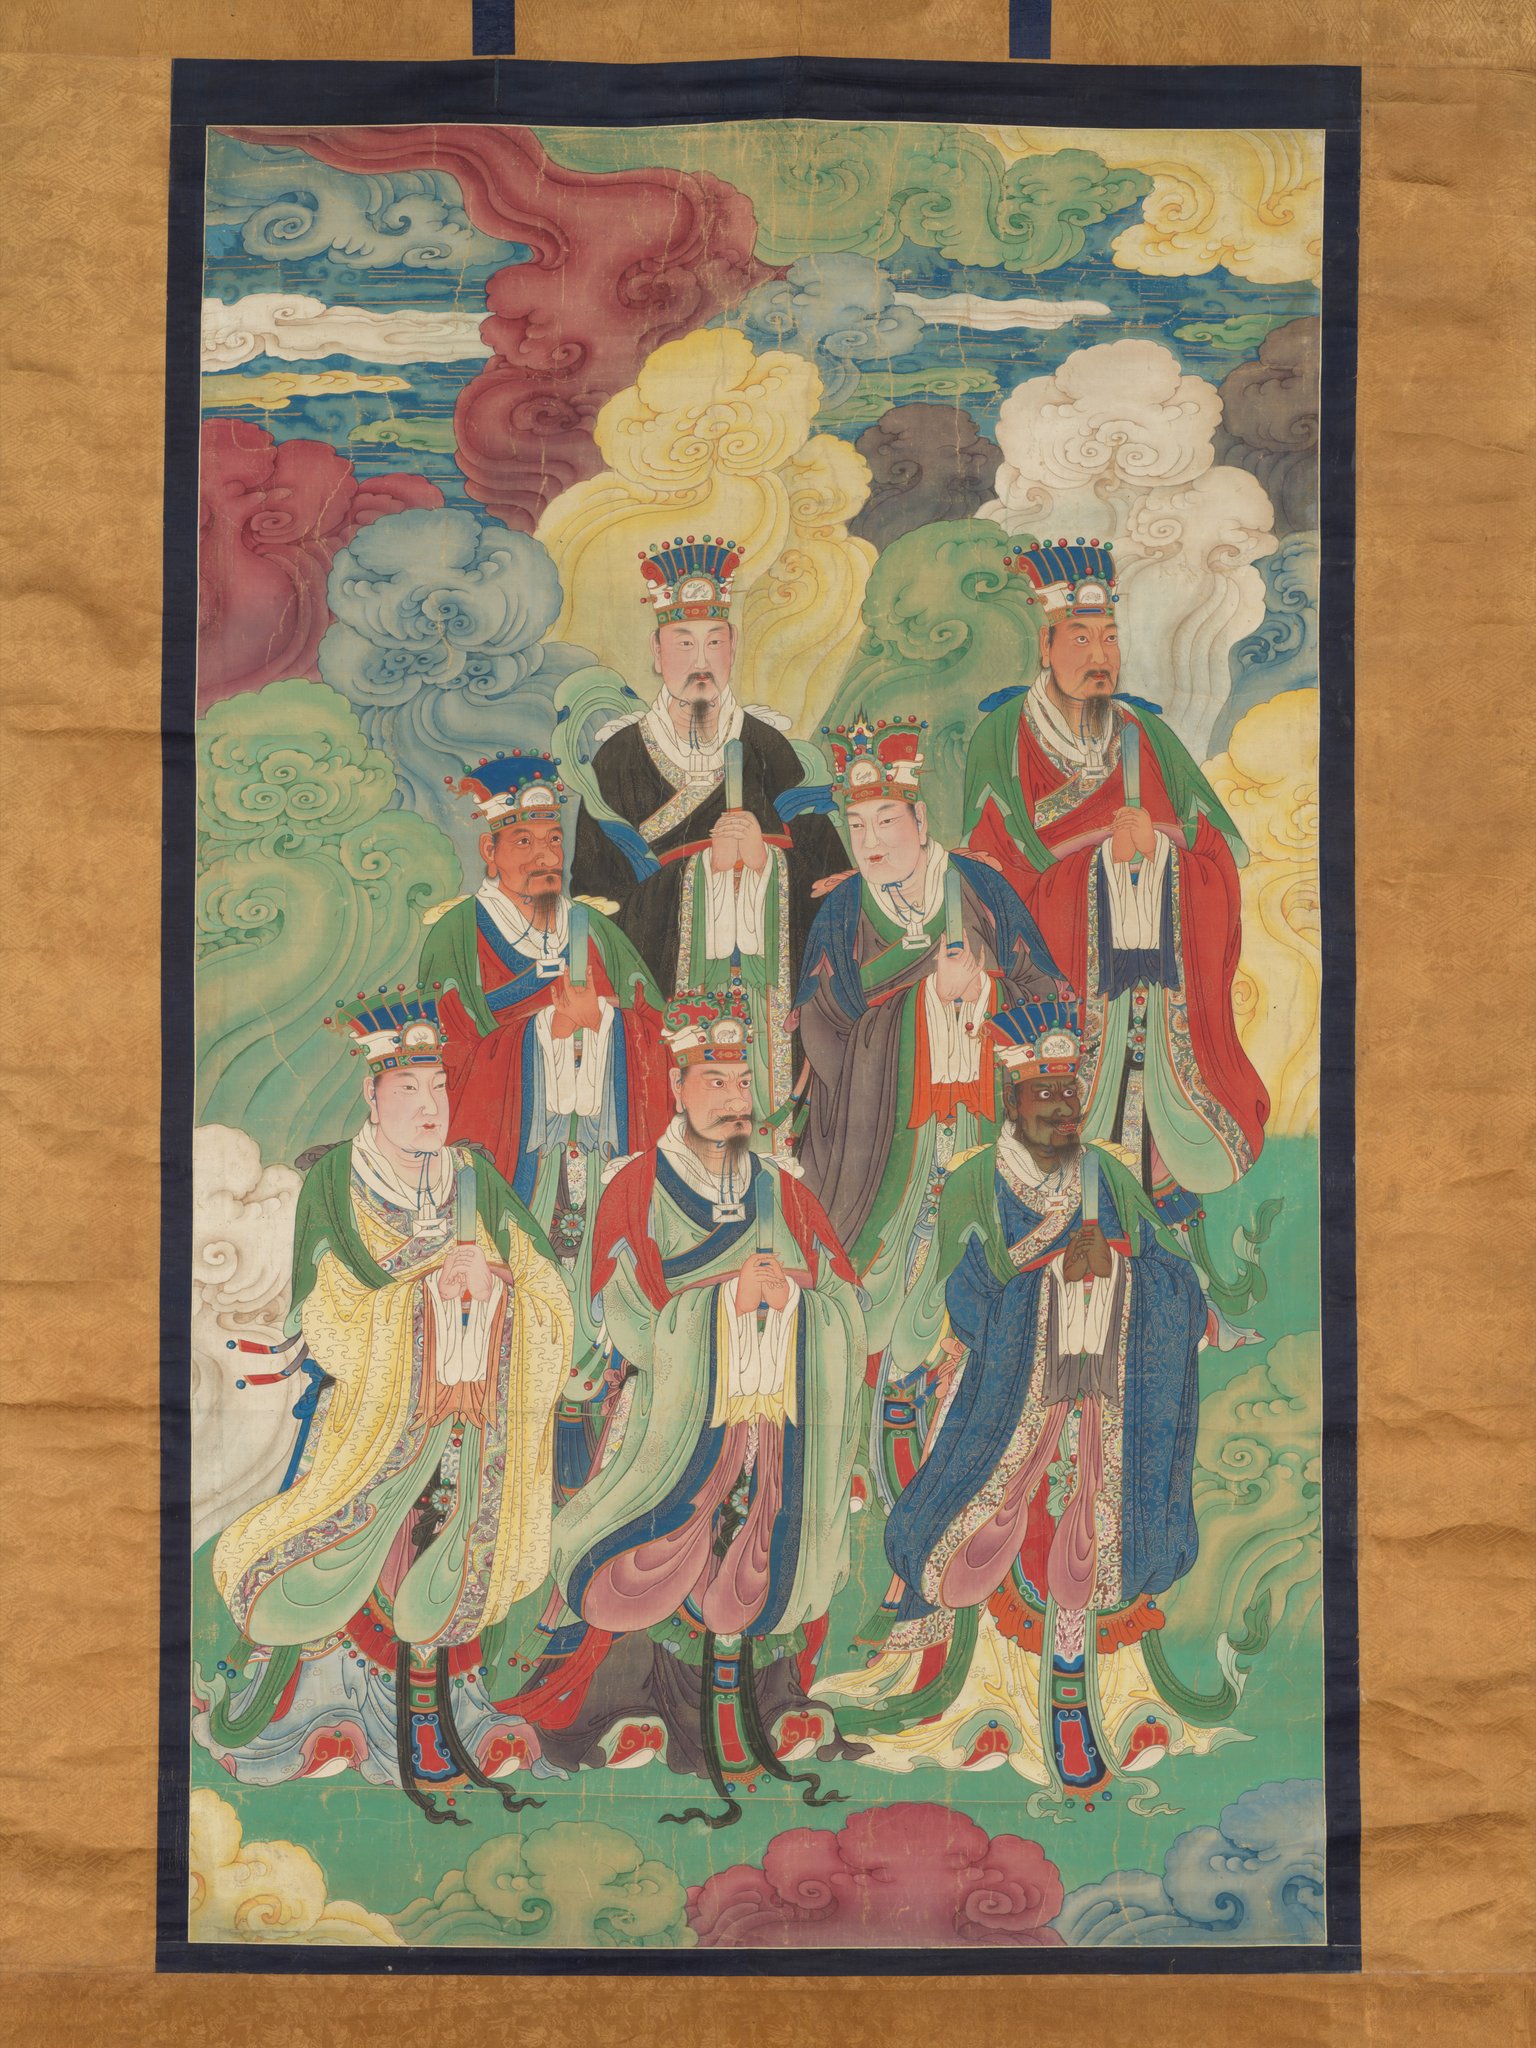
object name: hanging scroll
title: Seven Heavenly Emperors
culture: chinese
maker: unidentified artist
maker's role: artist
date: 1368-1911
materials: ink, paper